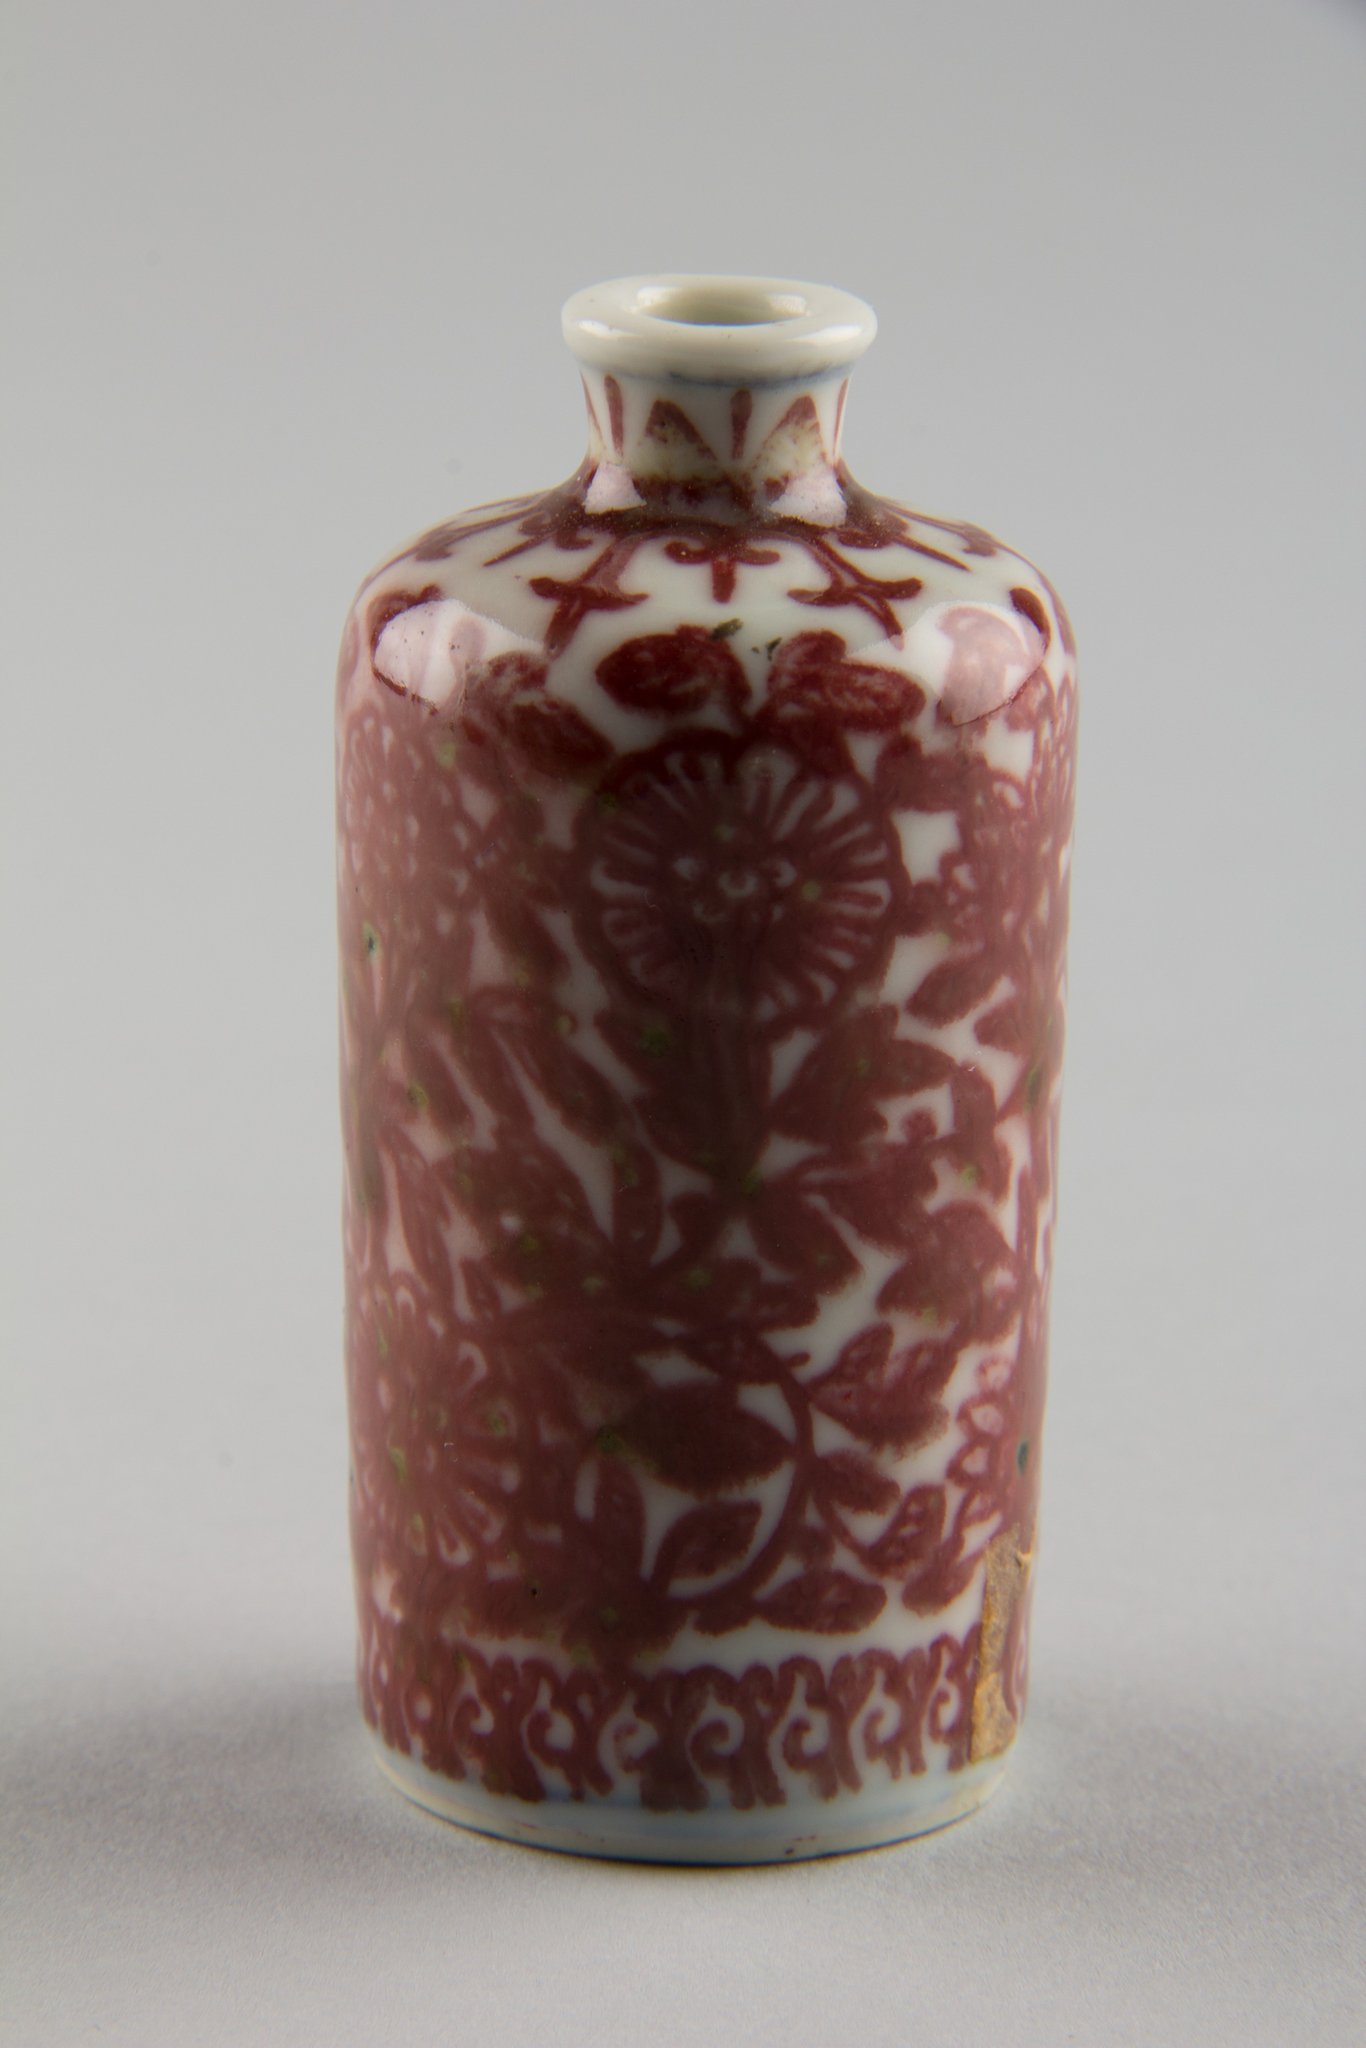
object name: bottle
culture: chinese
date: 1640-1911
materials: porcelain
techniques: painting, underglaze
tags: flowers,leaves